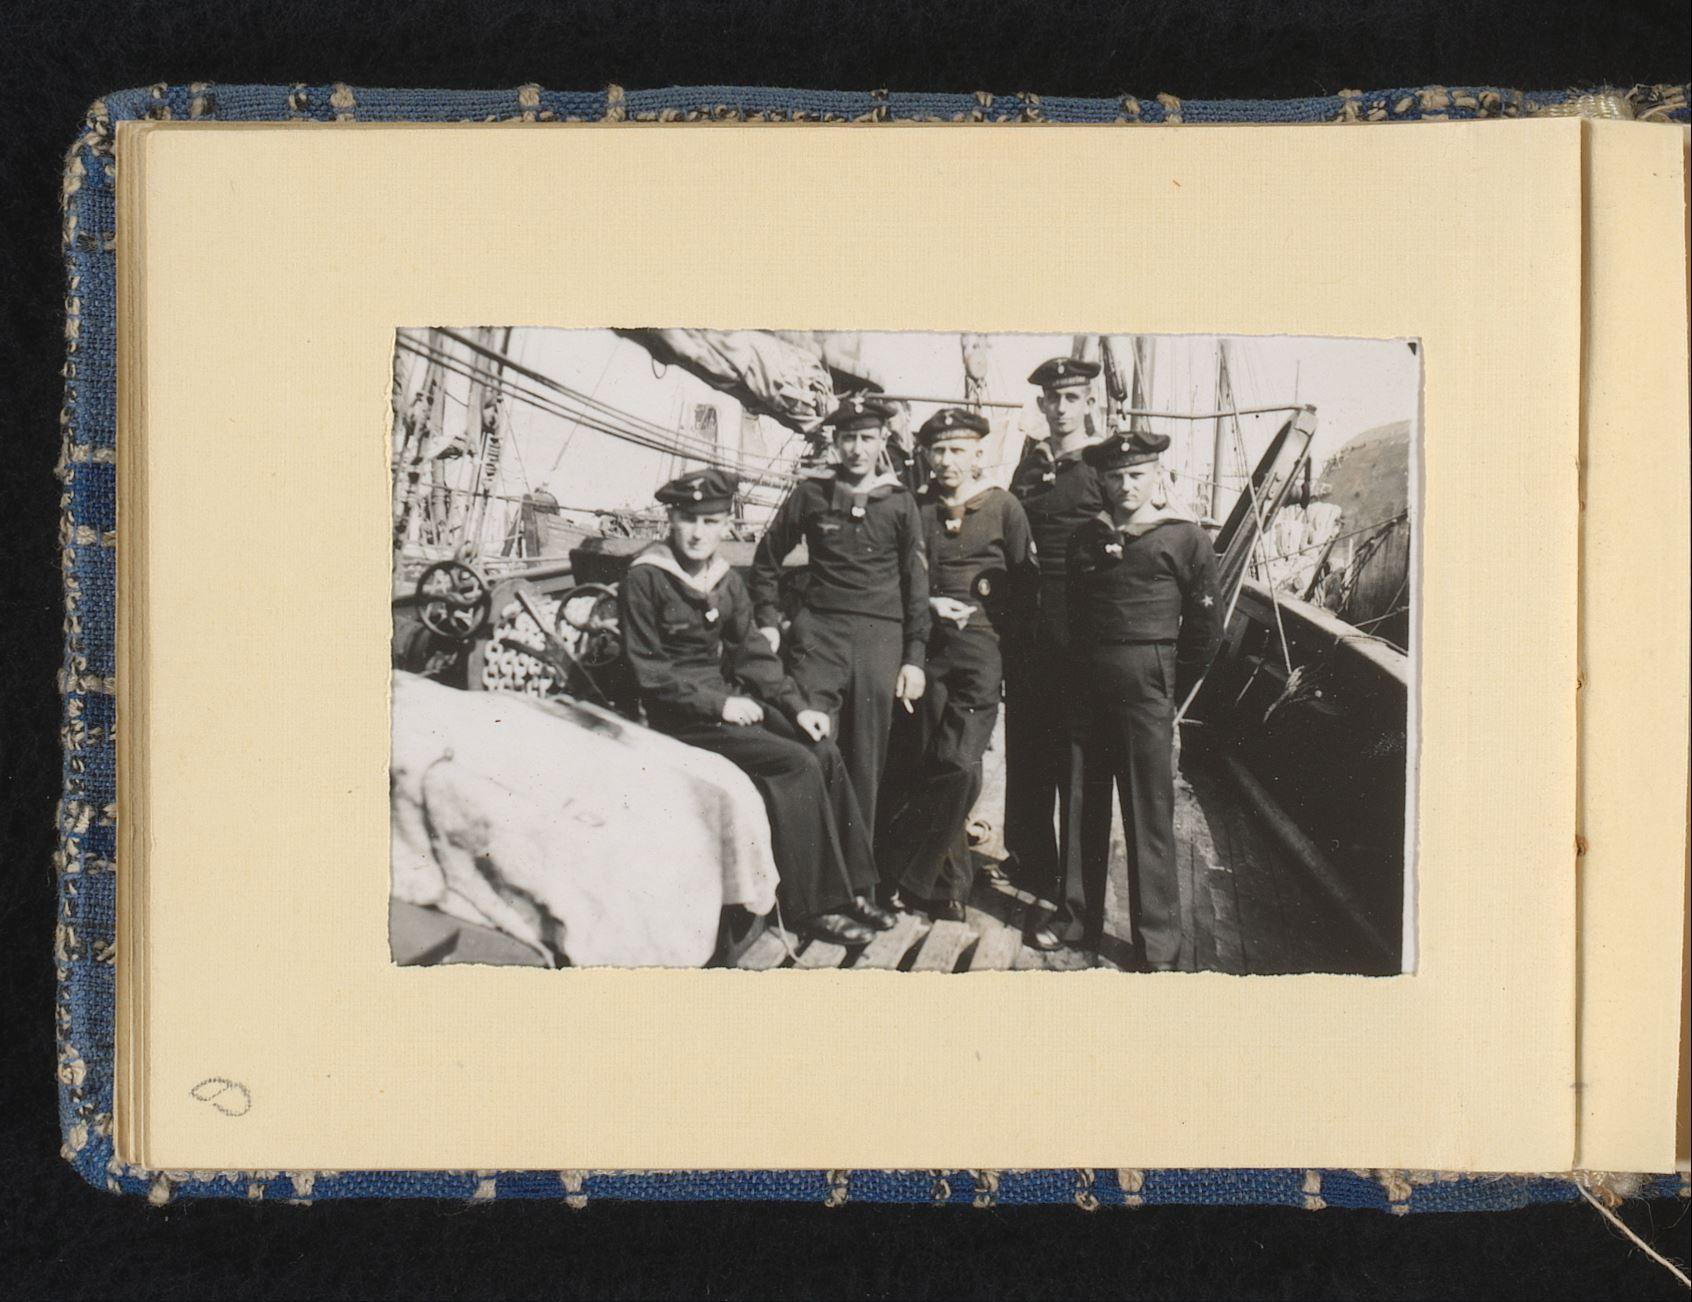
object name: photograph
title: Groepsfoto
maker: Anonymous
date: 1940-1943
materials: photographic support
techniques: gelatin silver print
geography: netherlands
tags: the company, the unit, the troop ~ military service, sailor, netherlands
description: Groepsfoto van een aantal Duitse matrozen op het dek van een schip. Onderdeel van het fotoalbum over de Kriegsmarine 1940-1943.